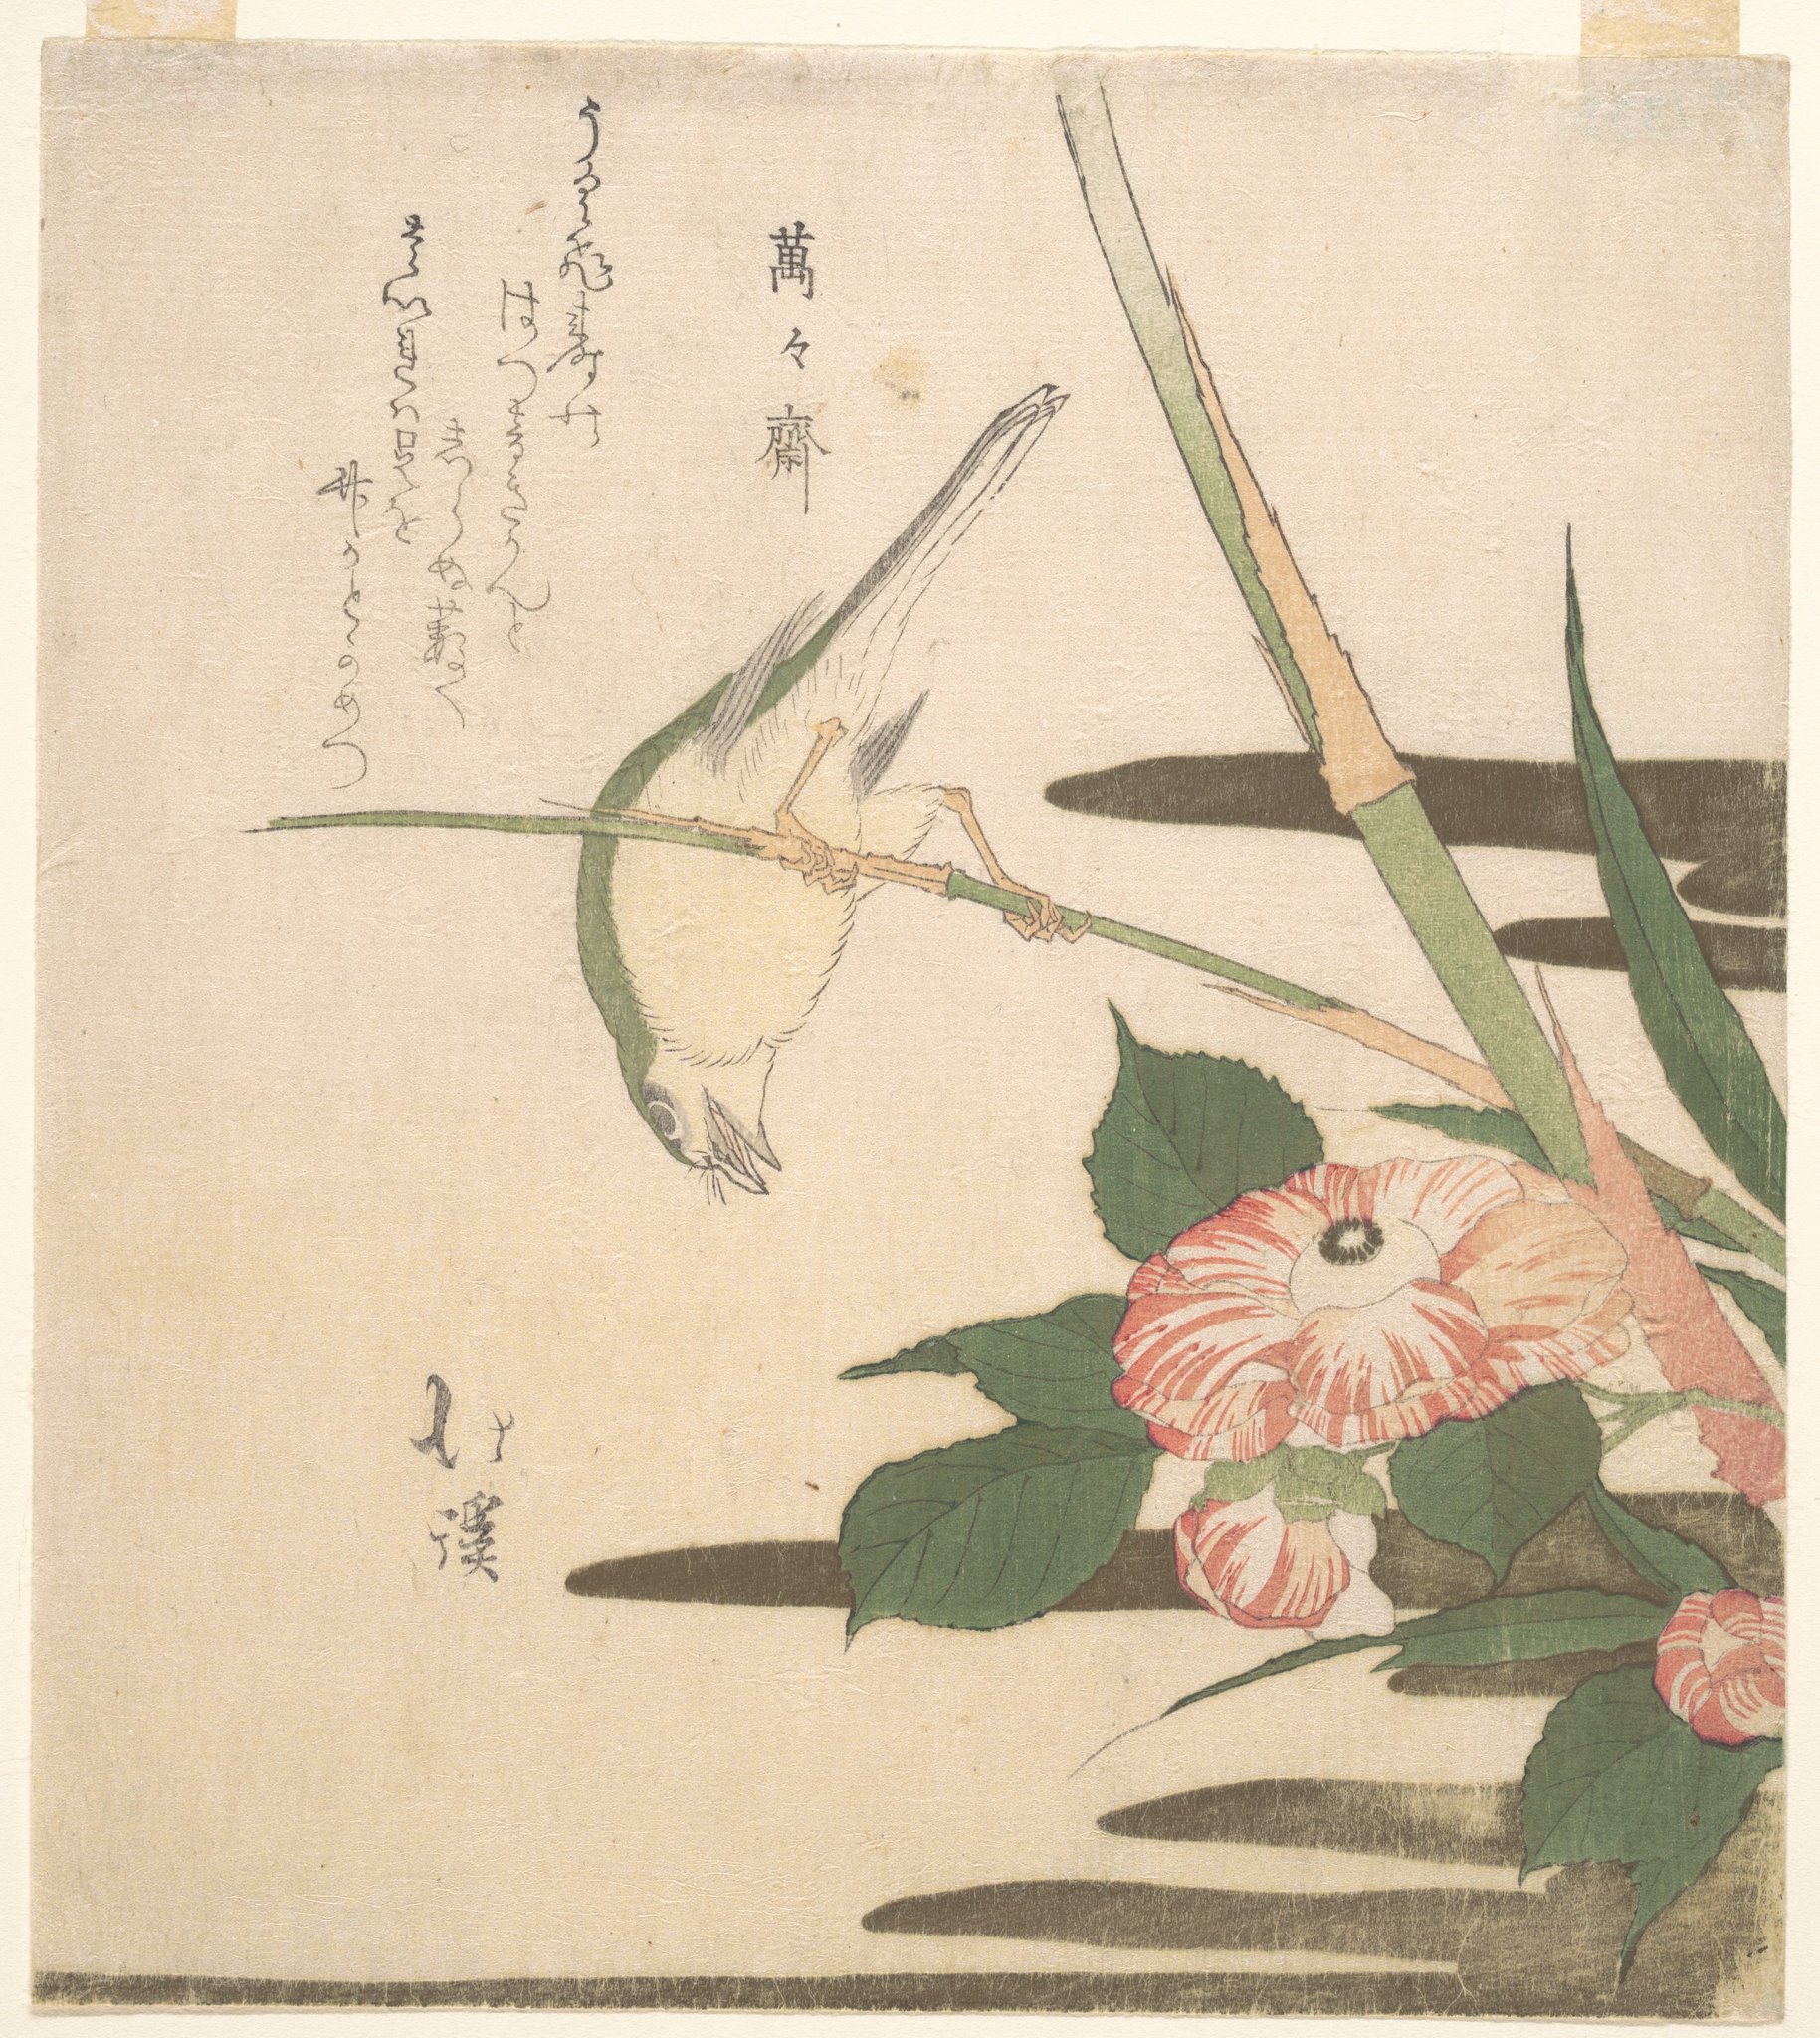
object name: print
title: Warbler and Camellia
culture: japanese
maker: totoya hokkei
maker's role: artist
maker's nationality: japanese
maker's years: 1780-1850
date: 1815-1820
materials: ink, paper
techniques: surimono, woodblock print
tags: birds,flowers,leaves